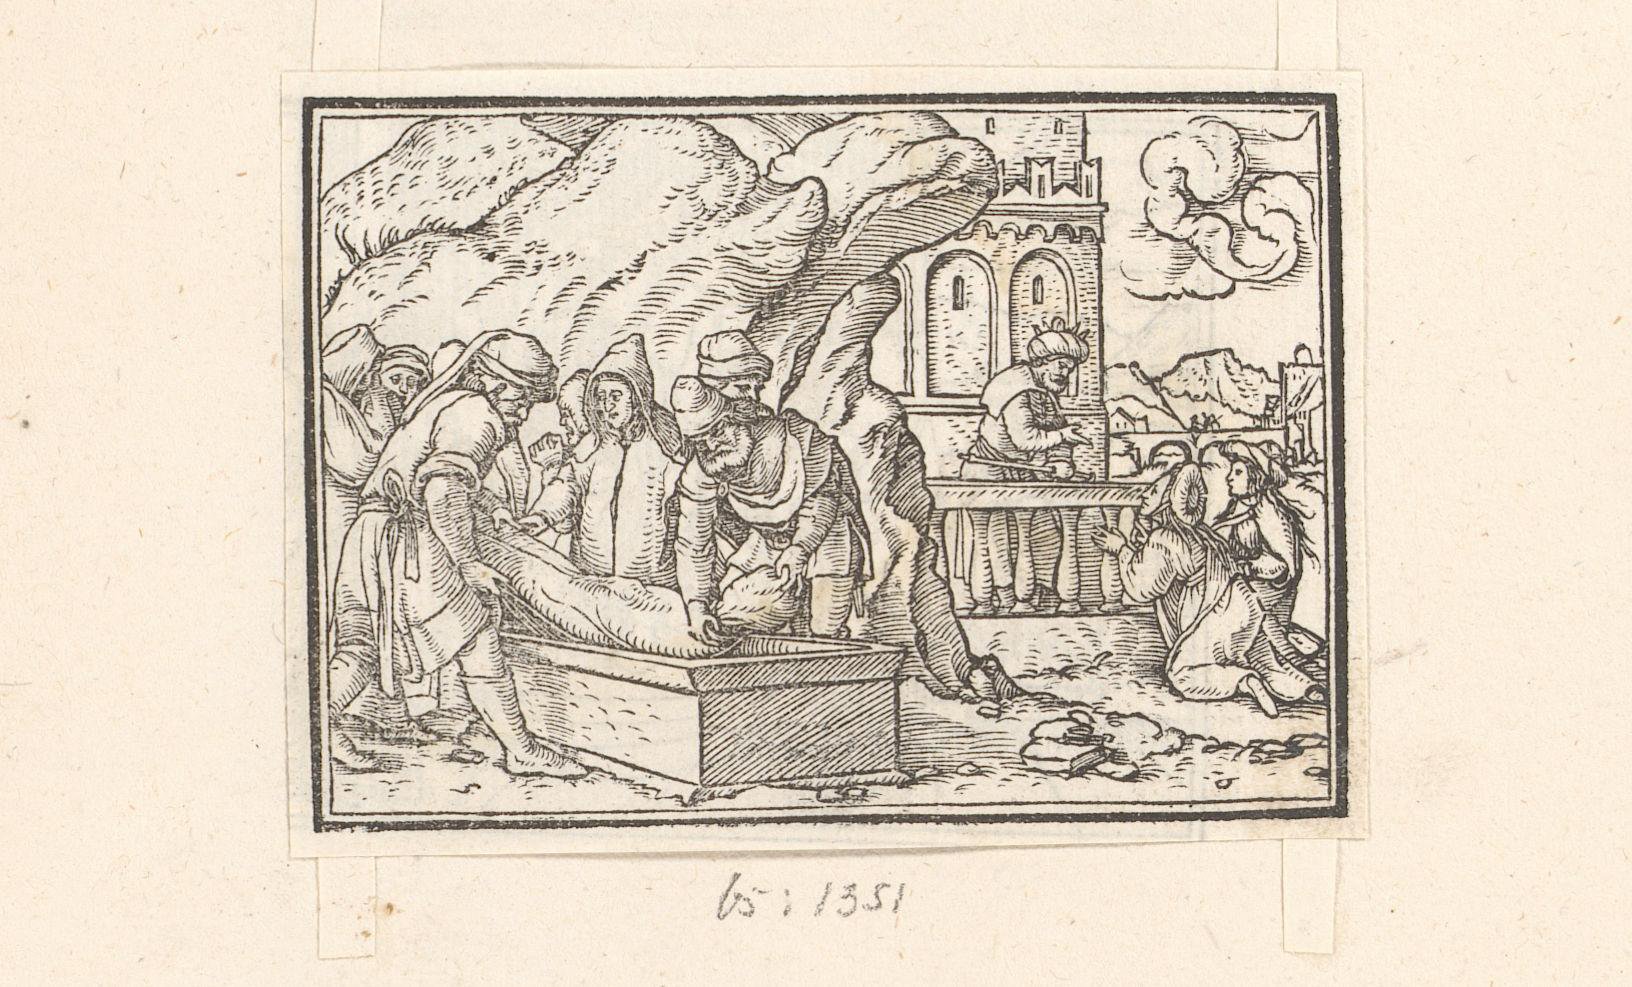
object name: print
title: Geschiedenis van het Oude Testament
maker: veit rudolf specklin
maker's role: print maker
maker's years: -1550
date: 1538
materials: paper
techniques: woodcut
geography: switzerland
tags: jacob is buried in the cave of machpelah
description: Boekillustratie voor het eerst gebruikt in: Biblia Utriusque Testamenti iuxta Vulgatam Translationem, Lyon, M. en G. Trechsel (voor Hugo à Porta) 1538. Later in verschillende uitgaven opnieuw gebruikt. Deze prent vermoedelijk gebruikt in één van de uitgaven uitgegeven en/of gedrukt door Jean Frellon, Lyon.